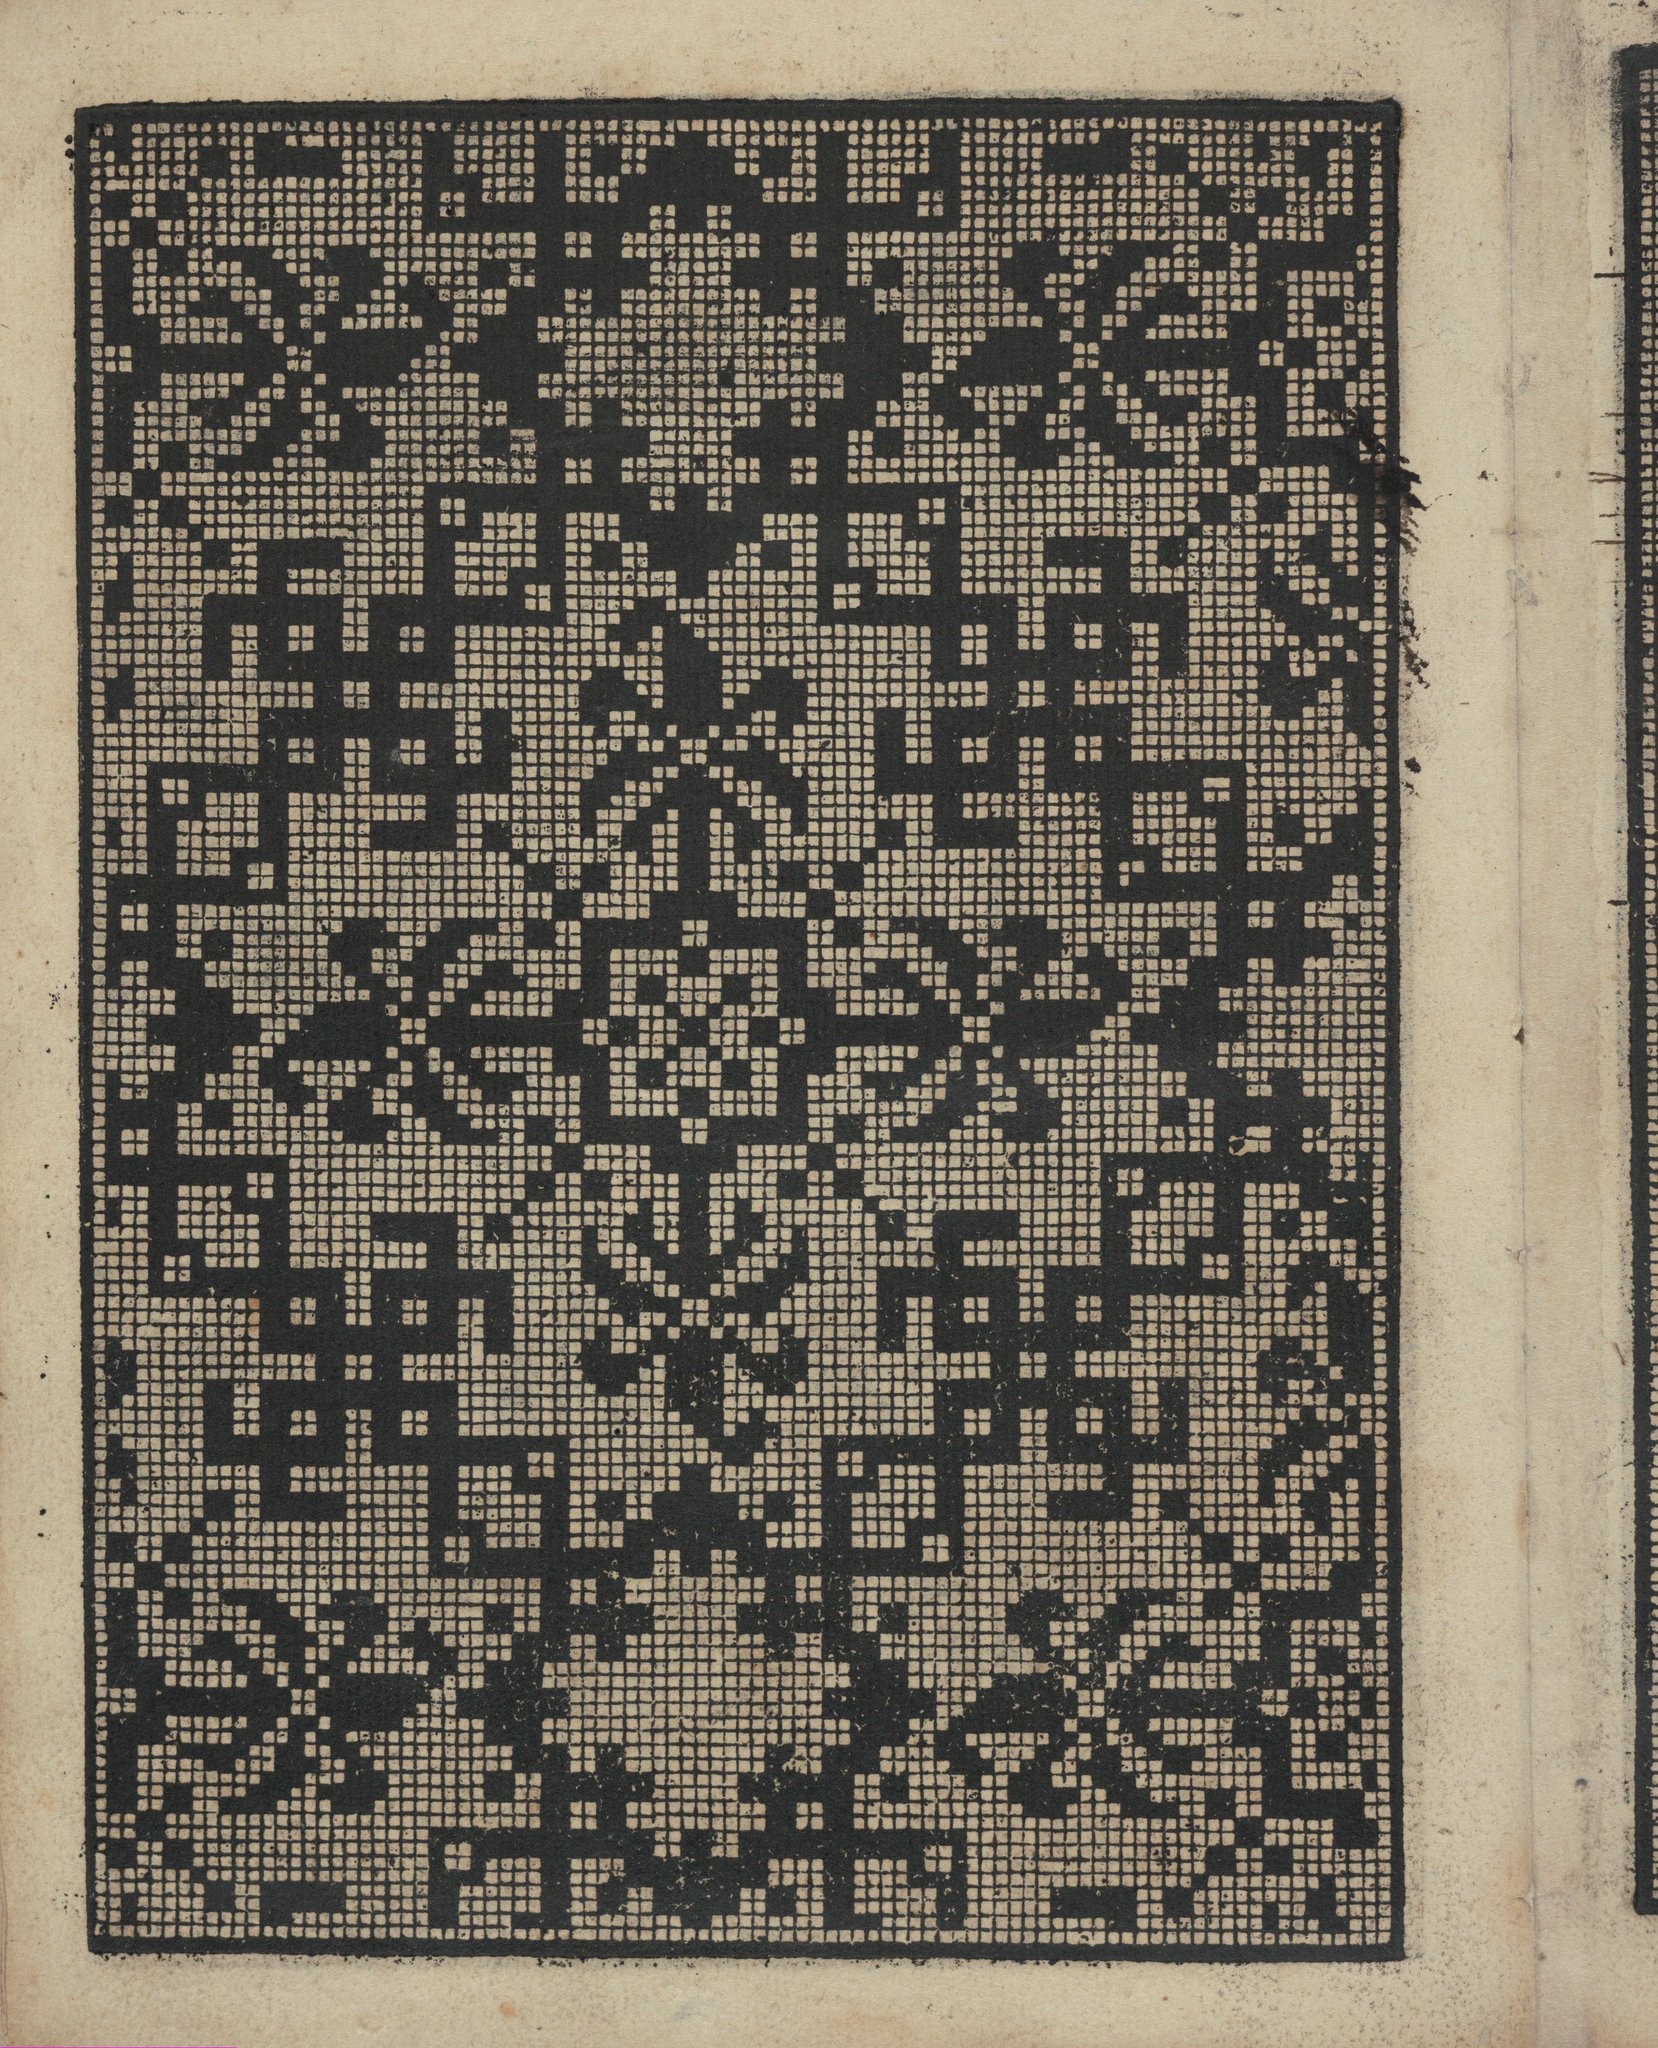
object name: book print ornament architecture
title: Libbretto nouellamete composto per maestro Domenico da Sera...lauorare di ogni sorte di punti, page 12 (verso)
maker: domenico da sera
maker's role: publisher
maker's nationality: french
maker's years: 1500-1599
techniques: woodcut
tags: ornament